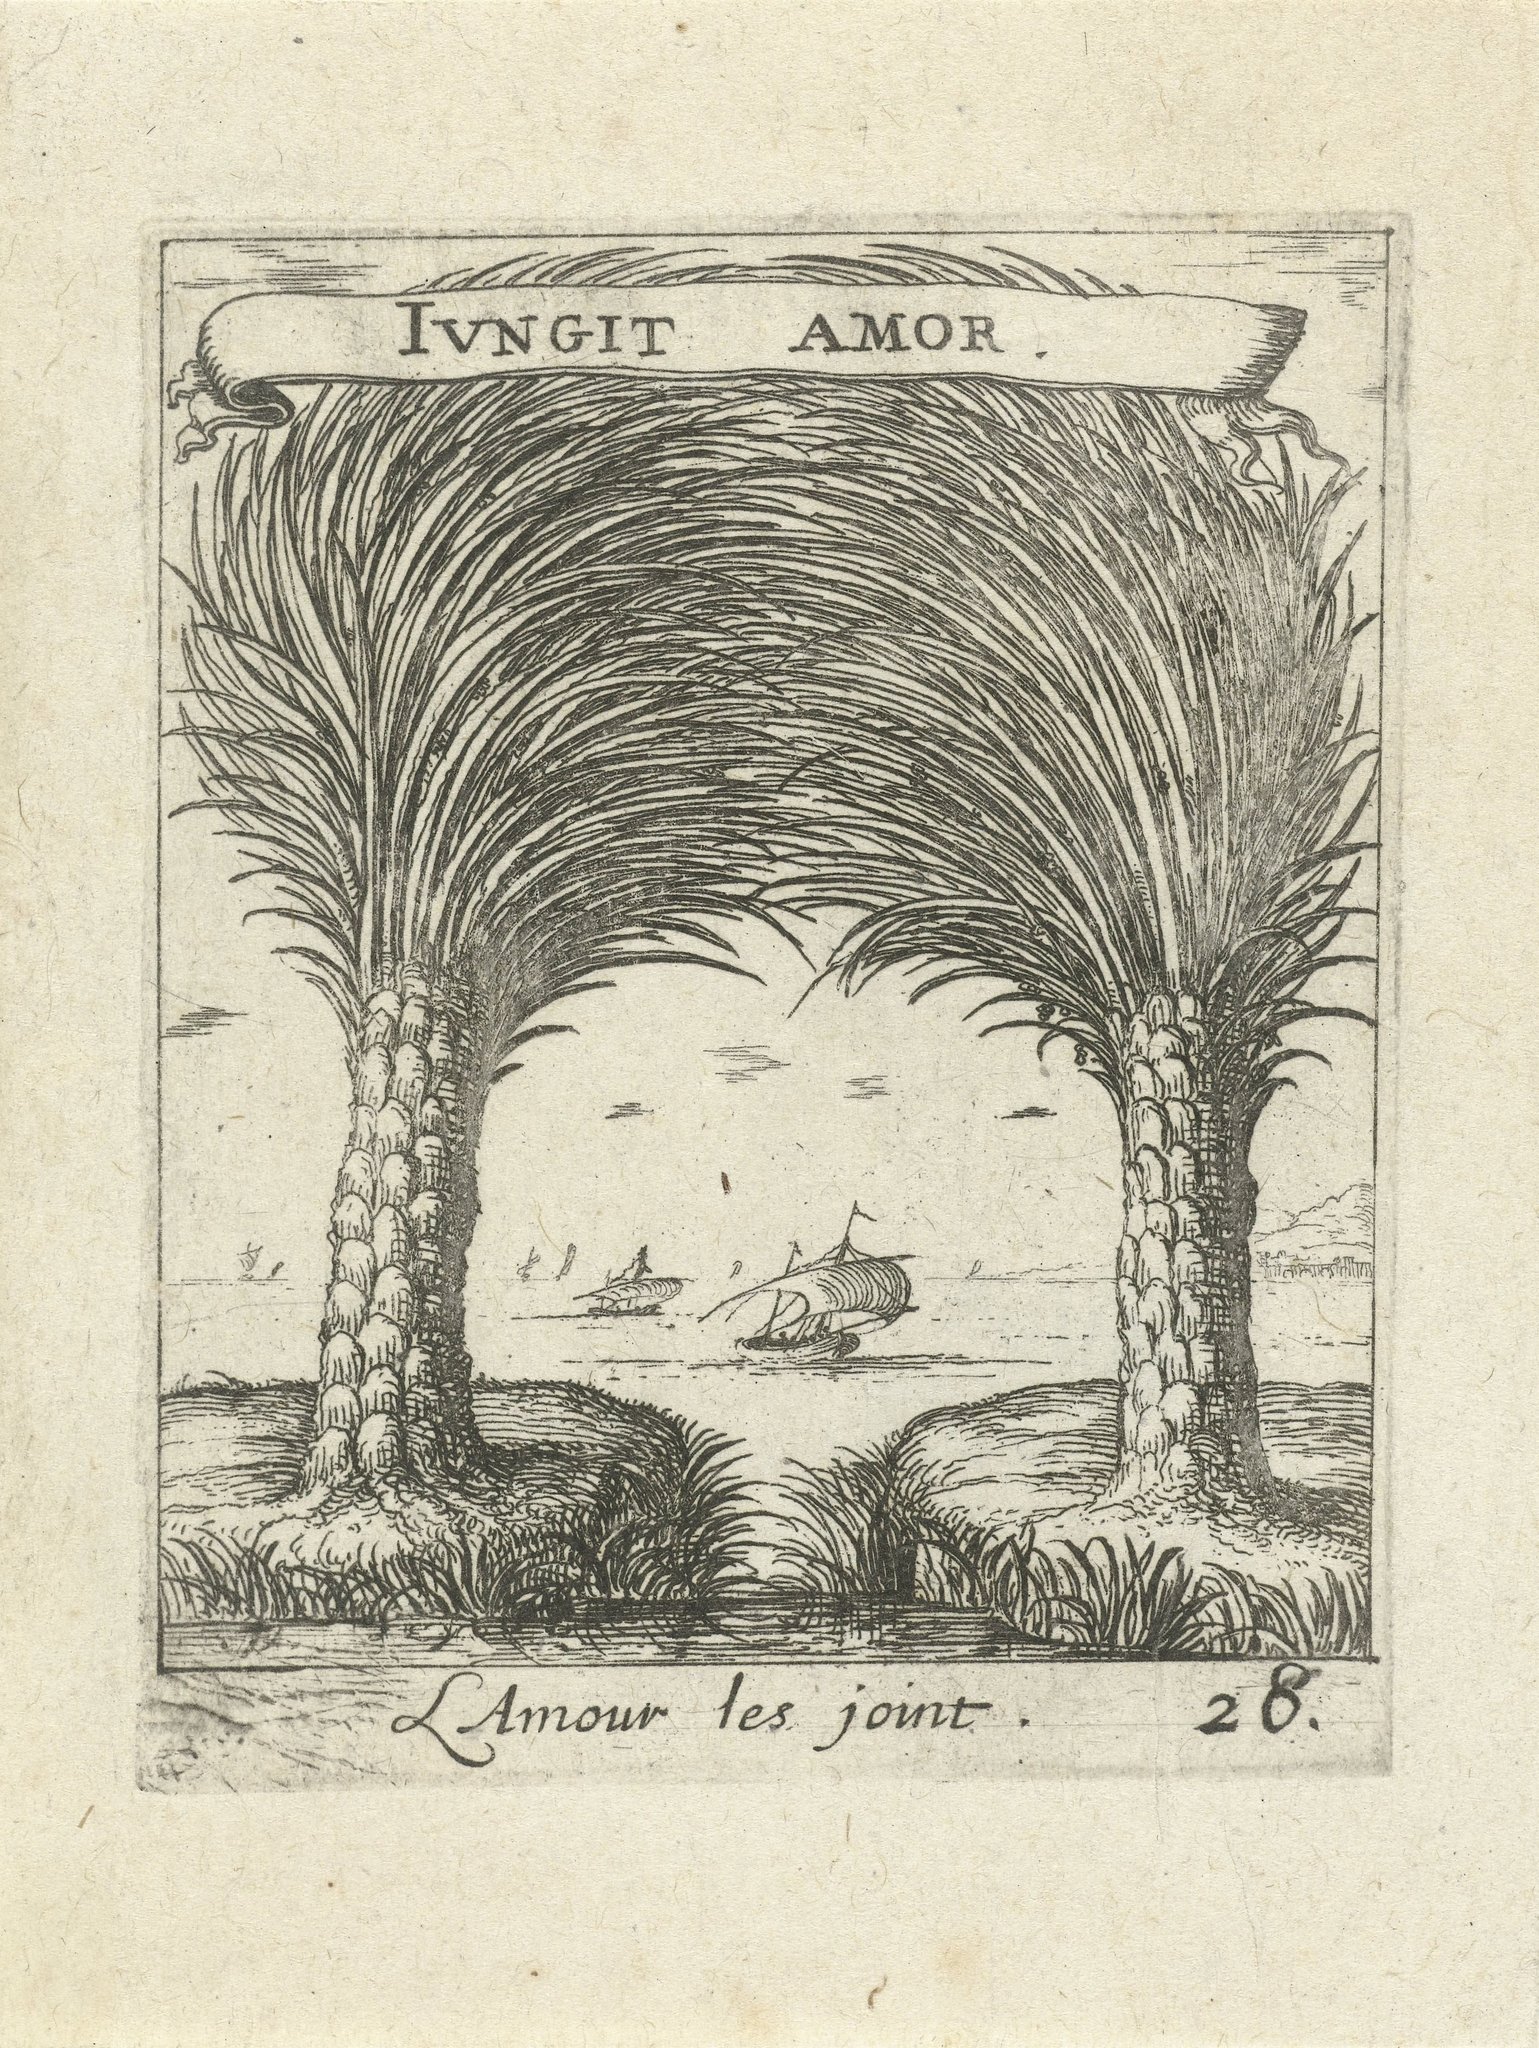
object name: print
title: Moraliserende liefdesemblemen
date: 1672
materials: paper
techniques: etching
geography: france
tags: qualities of love: first series (+ emblematical representation of concept)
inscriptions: collector's mark: Lugt 2166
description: Een zeegezicht tussen twee, tegen elkaar aan groeiende, palmbomen door. Op een banderol een devies in Latijn en een onderschrift in Frans, beide over de liefde.